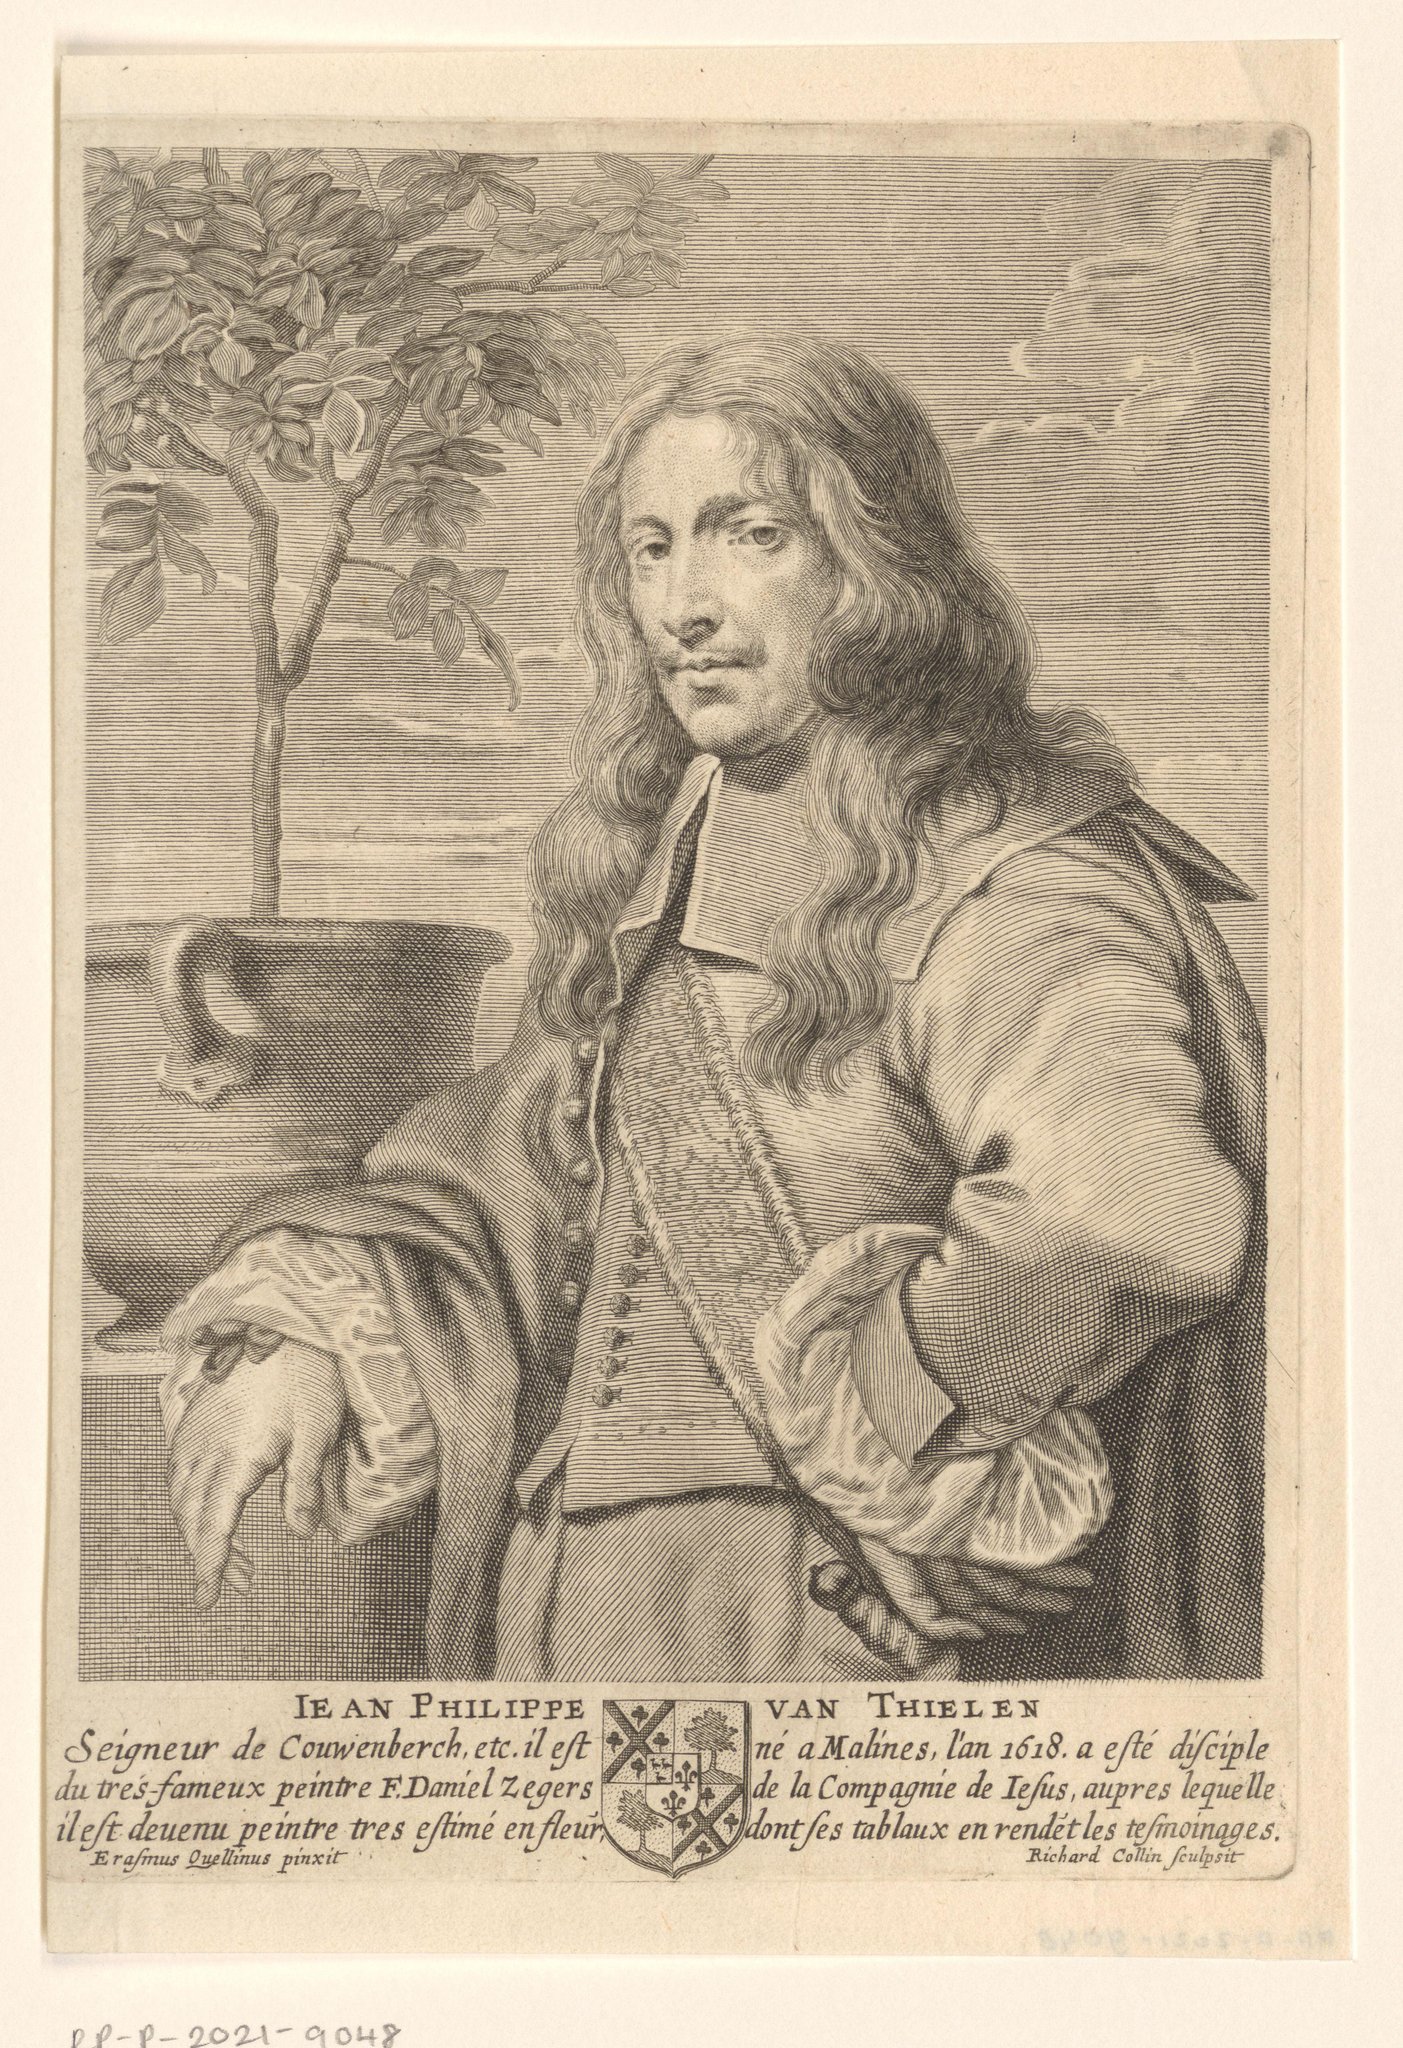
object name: print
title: Portret van Jan Philip van Thielen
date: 1661-1662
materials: paper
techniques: engraving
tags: mechelen, painter, jan philip van thielen, historical persons, portrait, self-portrait of painter, armorial bearing, heraldry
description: Prent met tekst op verso gebruikt in: Bie, Cornelis de. Het gulden cabinet vande edele vry schilder-const (...). Antwerpen: Juliaen van Montfort, 1662.